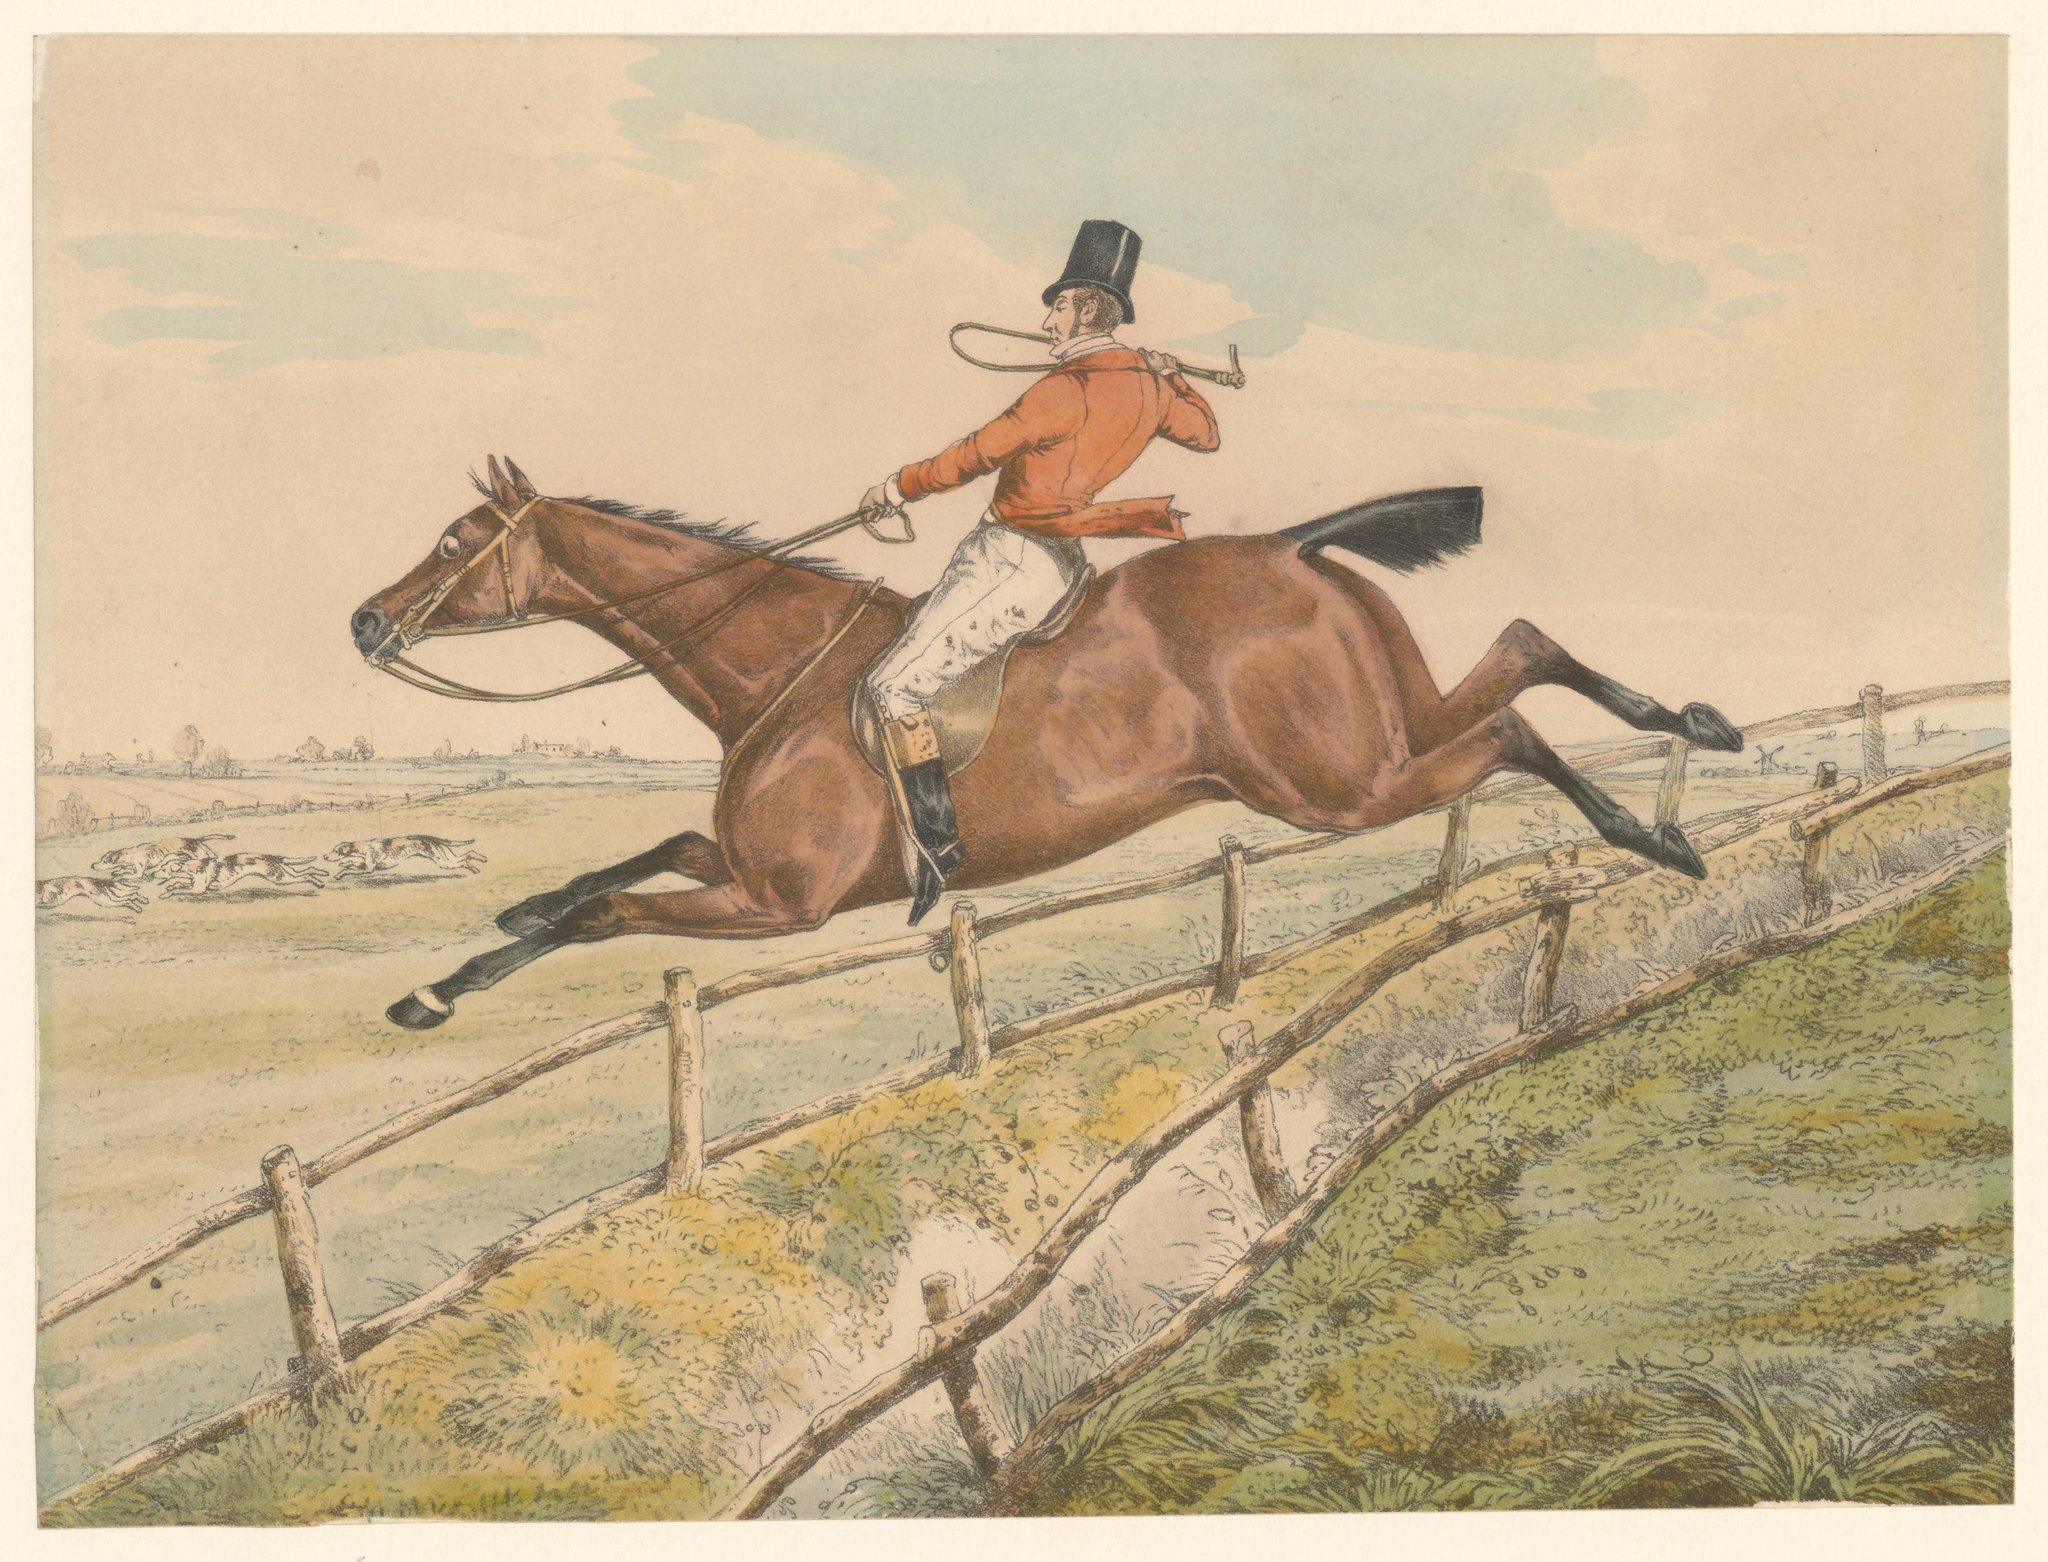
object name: print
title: Ruiter met paard over een hindernis springend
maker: henry alken (i)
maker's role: print maker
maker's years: 1774-1851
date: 1815-1827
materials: paper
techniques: etching, hand coloring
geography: england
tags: riding a horse, ass, or mule; rider, horseman, jumping (horse in motion)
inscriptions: collector's mark: Lugt 2228